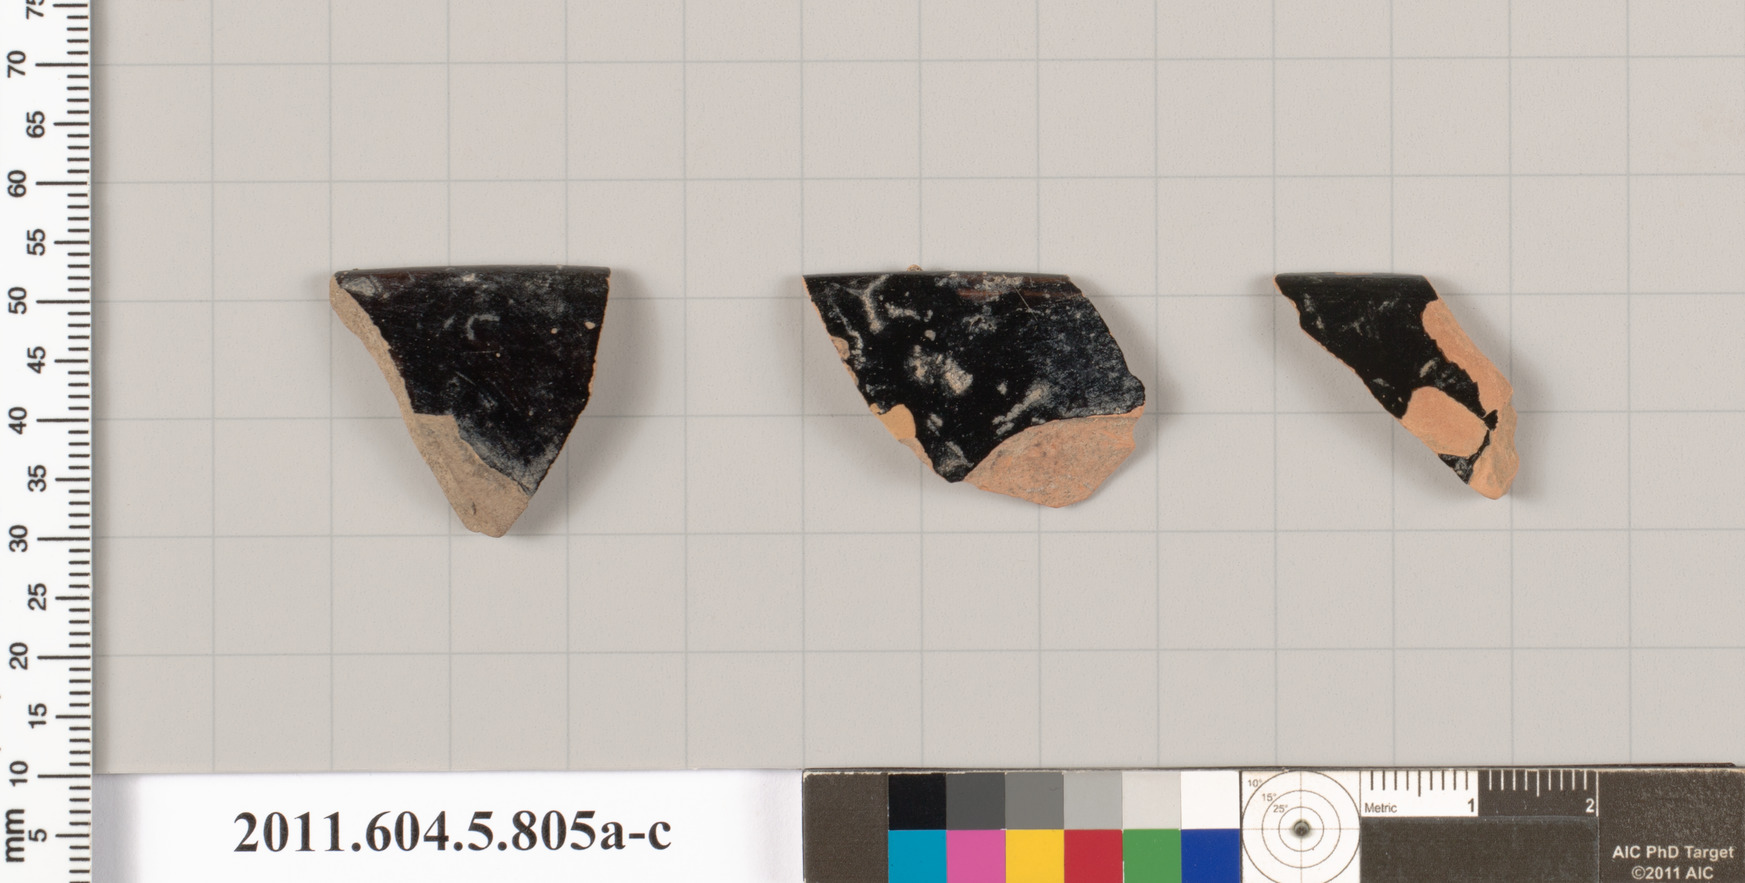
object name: kylix fragment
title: Terracotta rim fragments of kylikes (drinking cups)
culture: greek, attic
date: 600-401 BCE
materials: terracotta